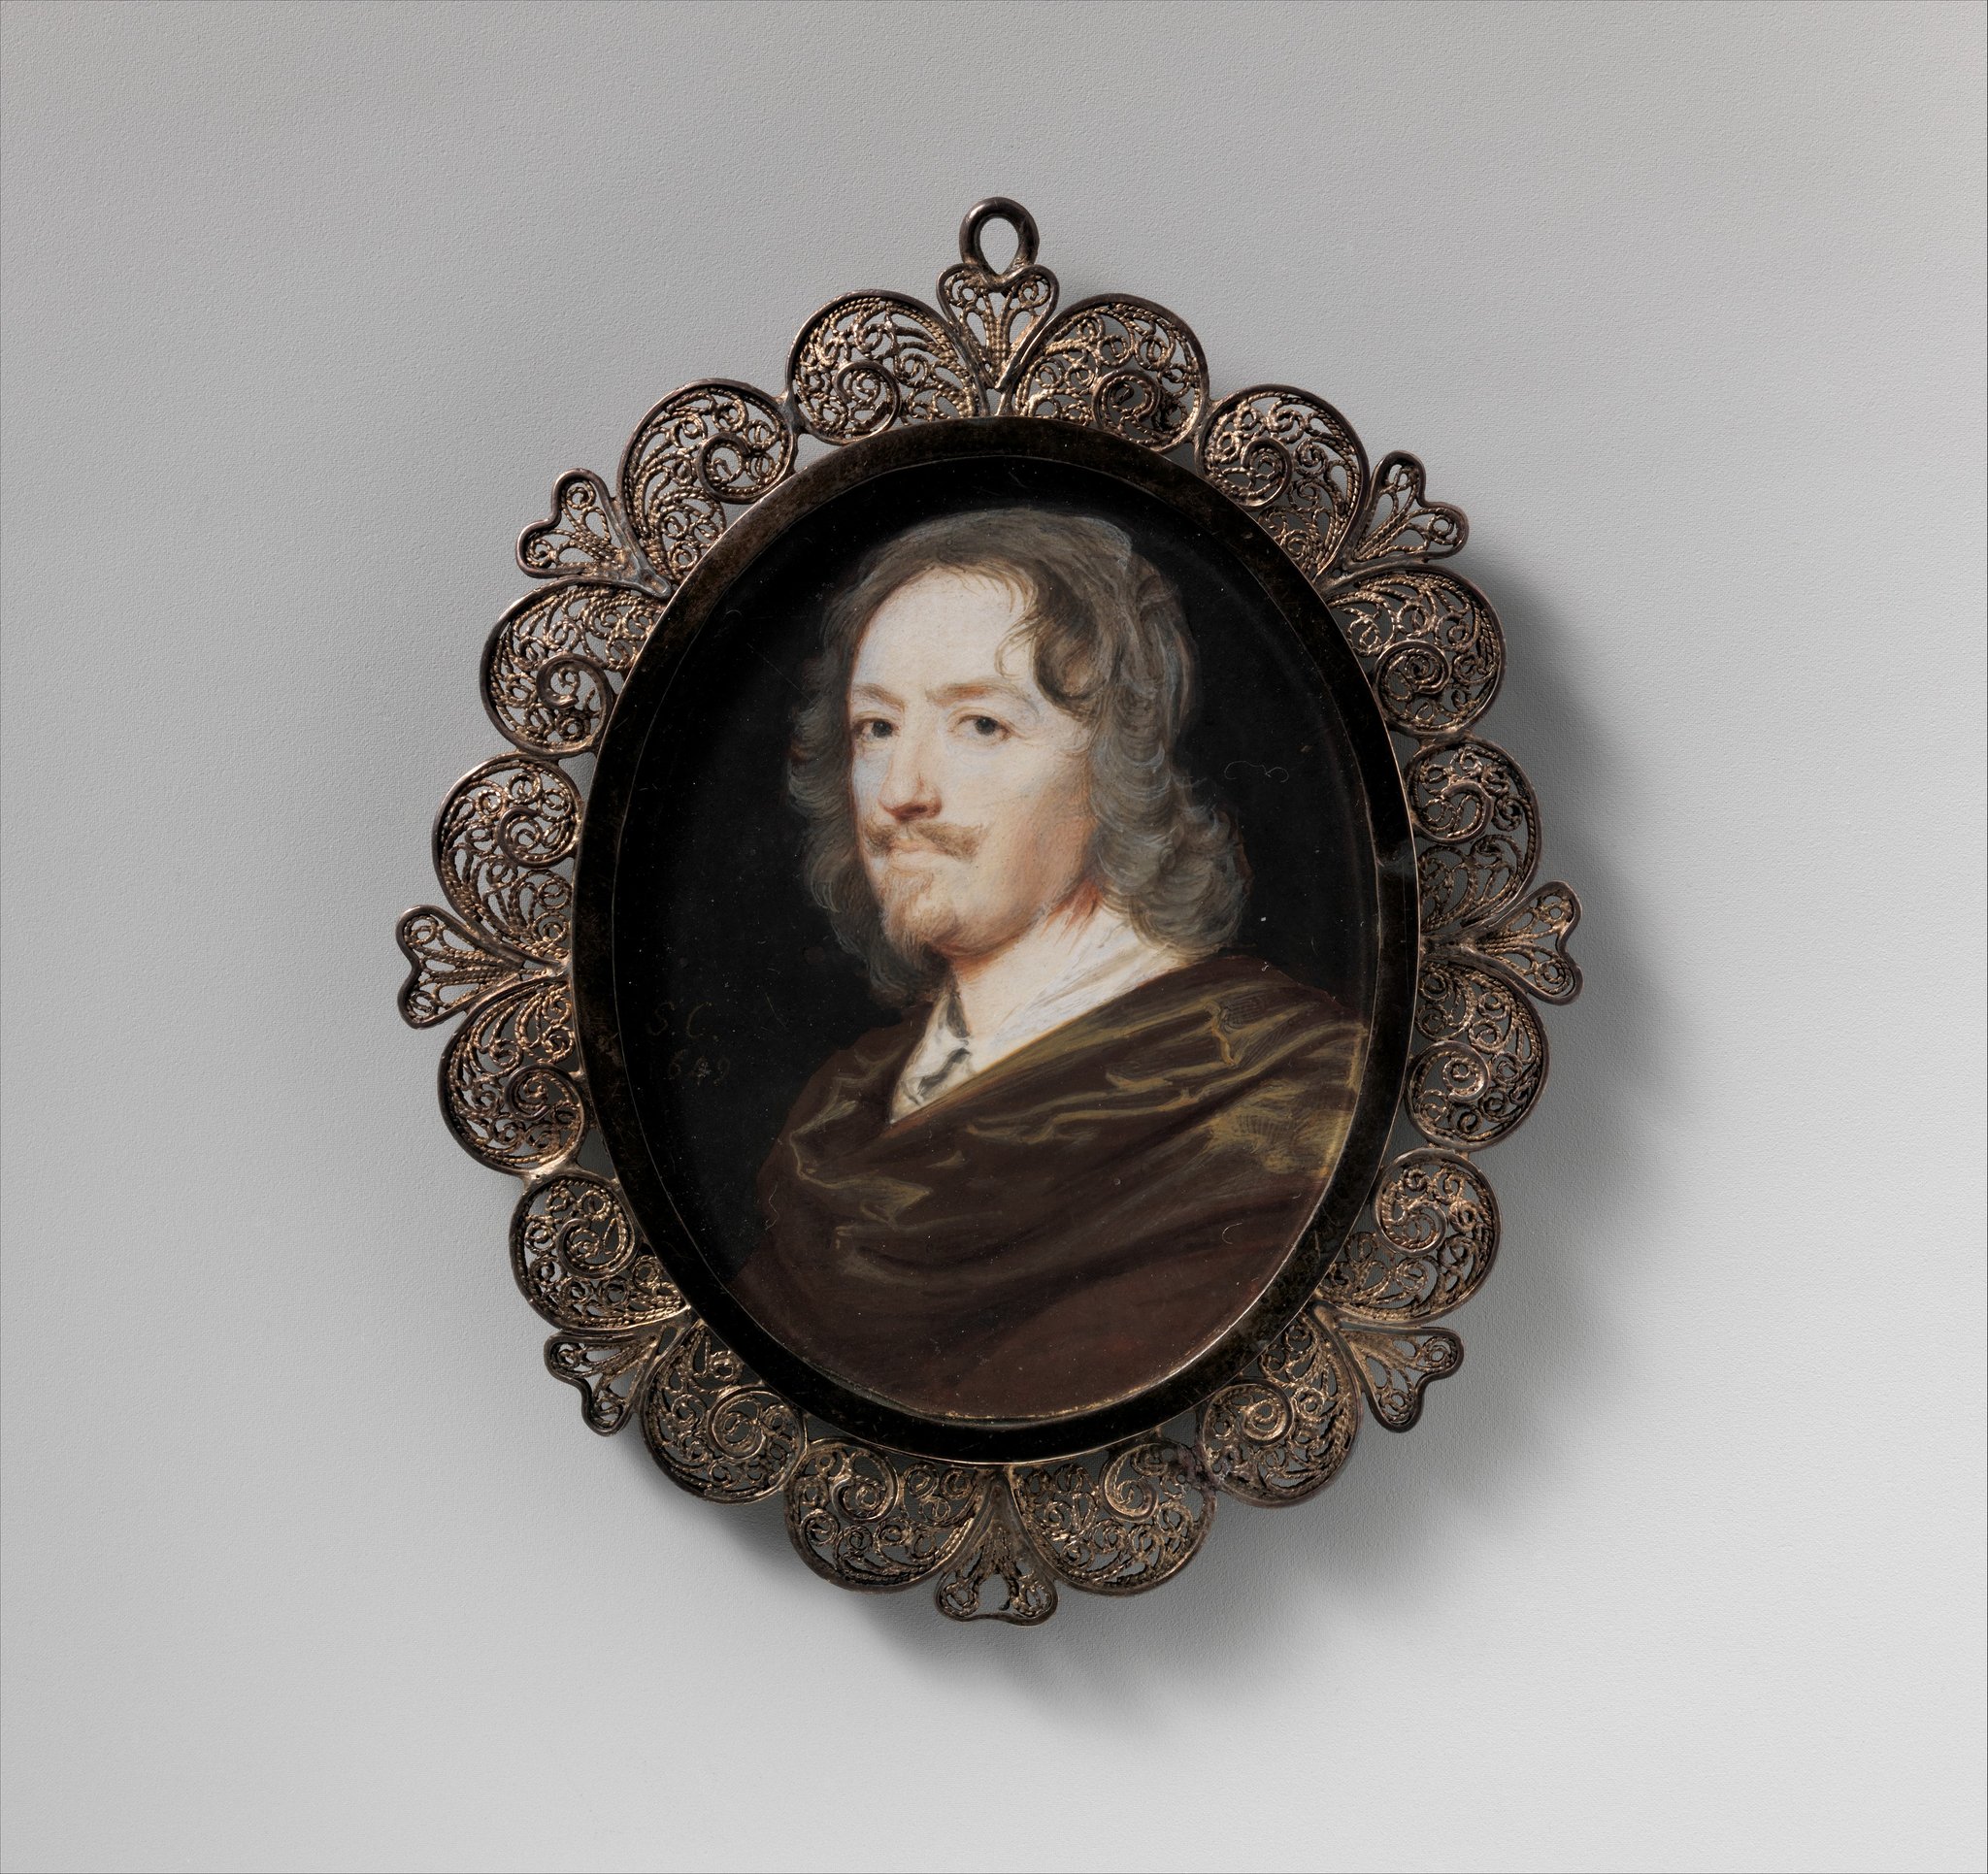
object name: painting, miniature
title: Henry Carey (1596–1661), Second Earl of Monmouth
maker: samuel cooper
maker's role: artist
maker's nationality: british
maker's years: 1608-1672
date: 1649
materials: parchment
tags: men,portraits